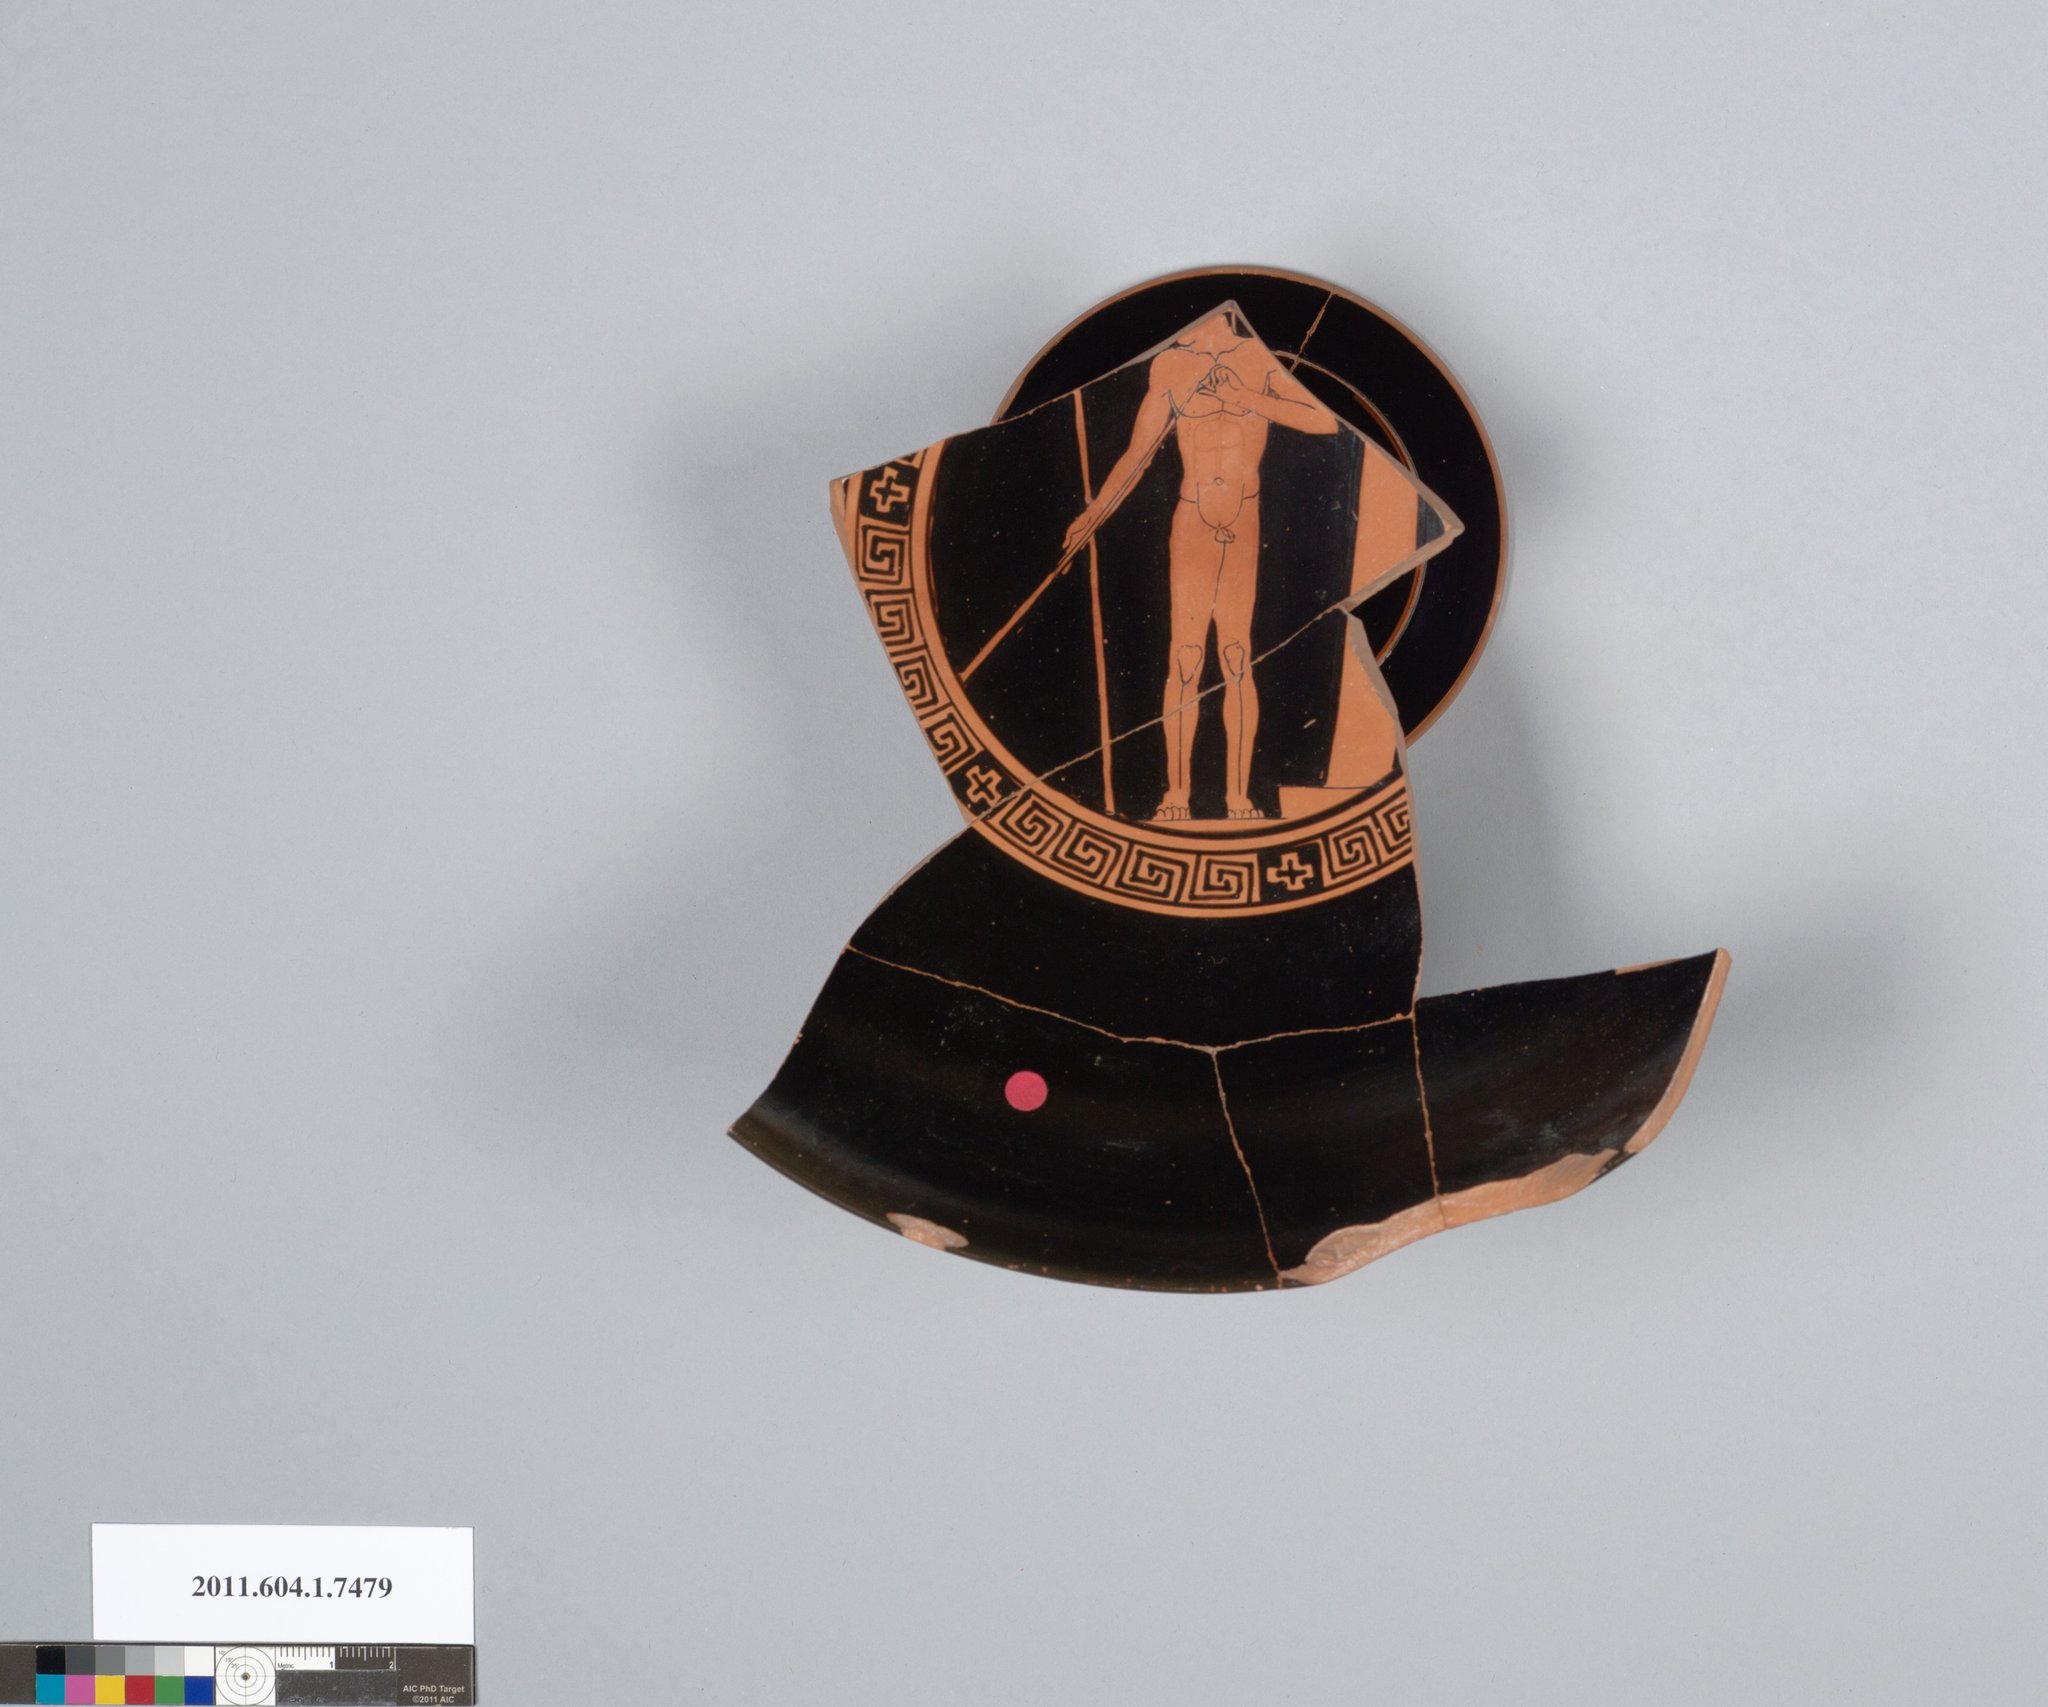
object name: kylix fragment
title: Terracotta fragment of a kylix (drinking cup)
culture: greek, attic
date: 470-460 BCE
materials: terracotta